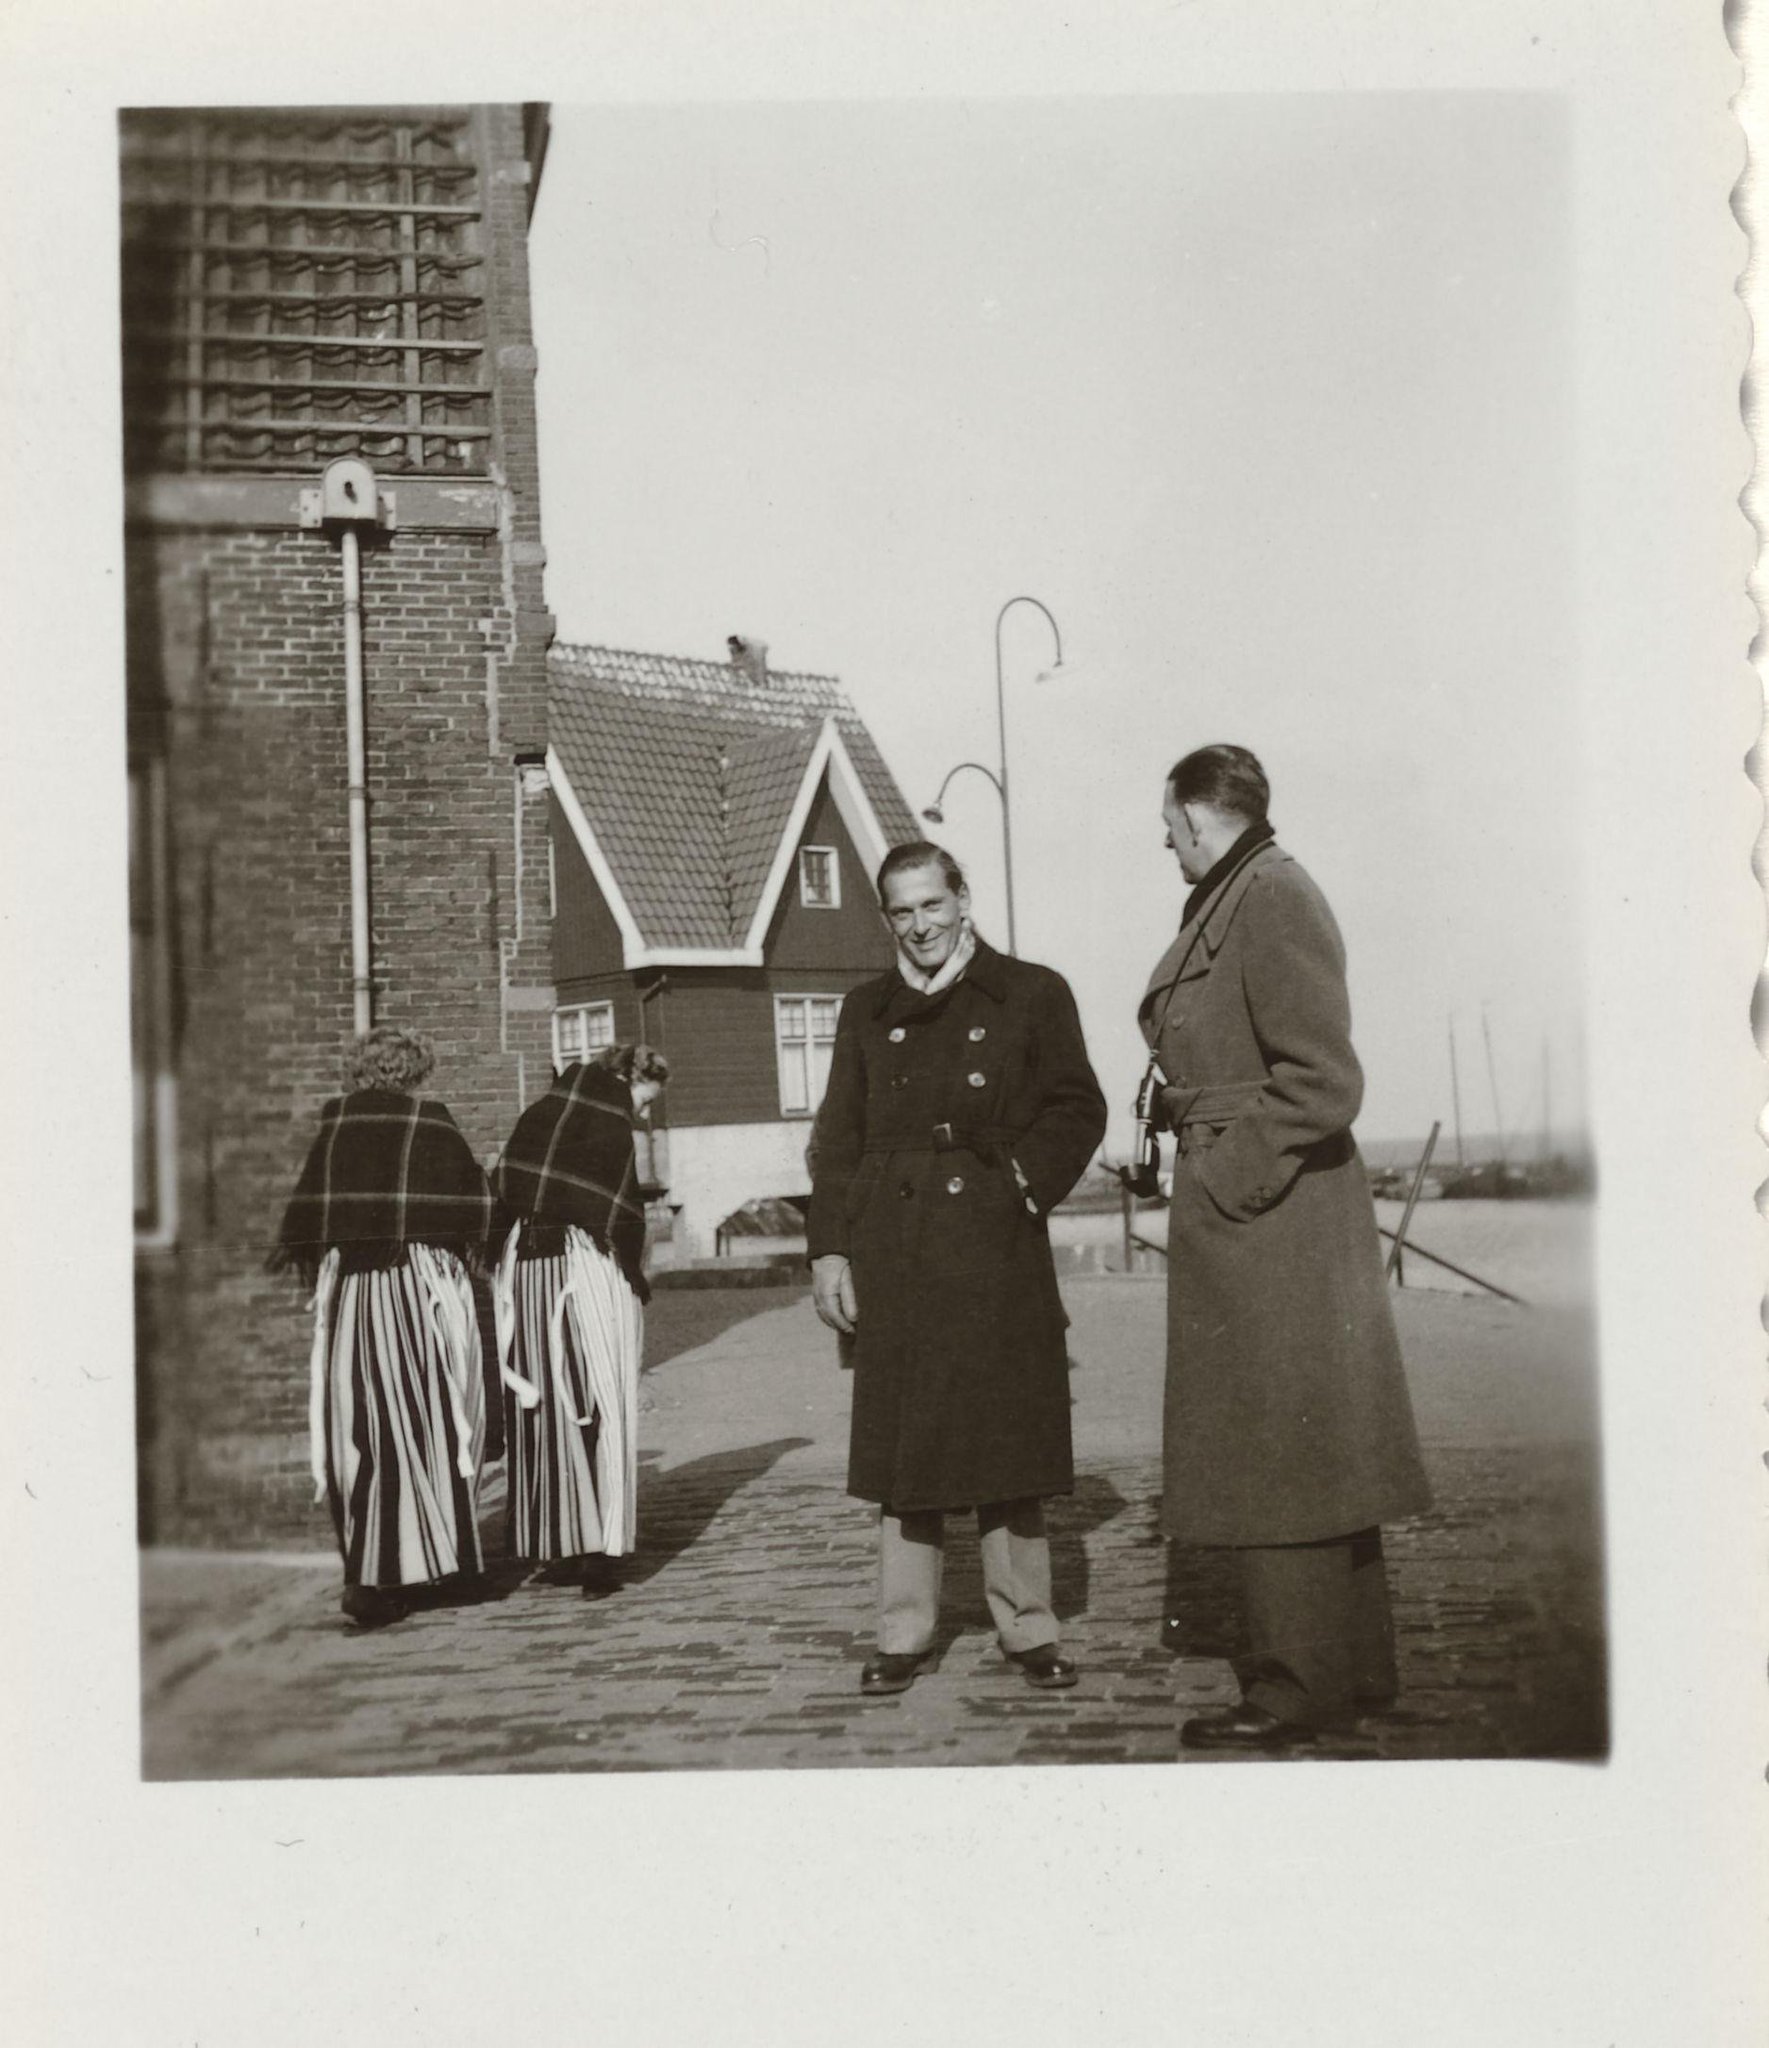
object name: photograph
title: Gideon Elon, de derde echtgenoot van Isabel Wachenheimer, in een Nederlandse stad naast twee vrouwen in Nederlandse klederdracht en een onbekende man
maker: Anonymous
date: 1956-1970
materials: photographic support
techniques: gelatin silver print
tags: gideon elon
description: Gideon Elon (tweede van rechts), de derde echtgenoot van Isabel Wachenheimer, in een Nederlandse stad naast twee vrouwen in Nederlandse klederdracht en een onbekende man.